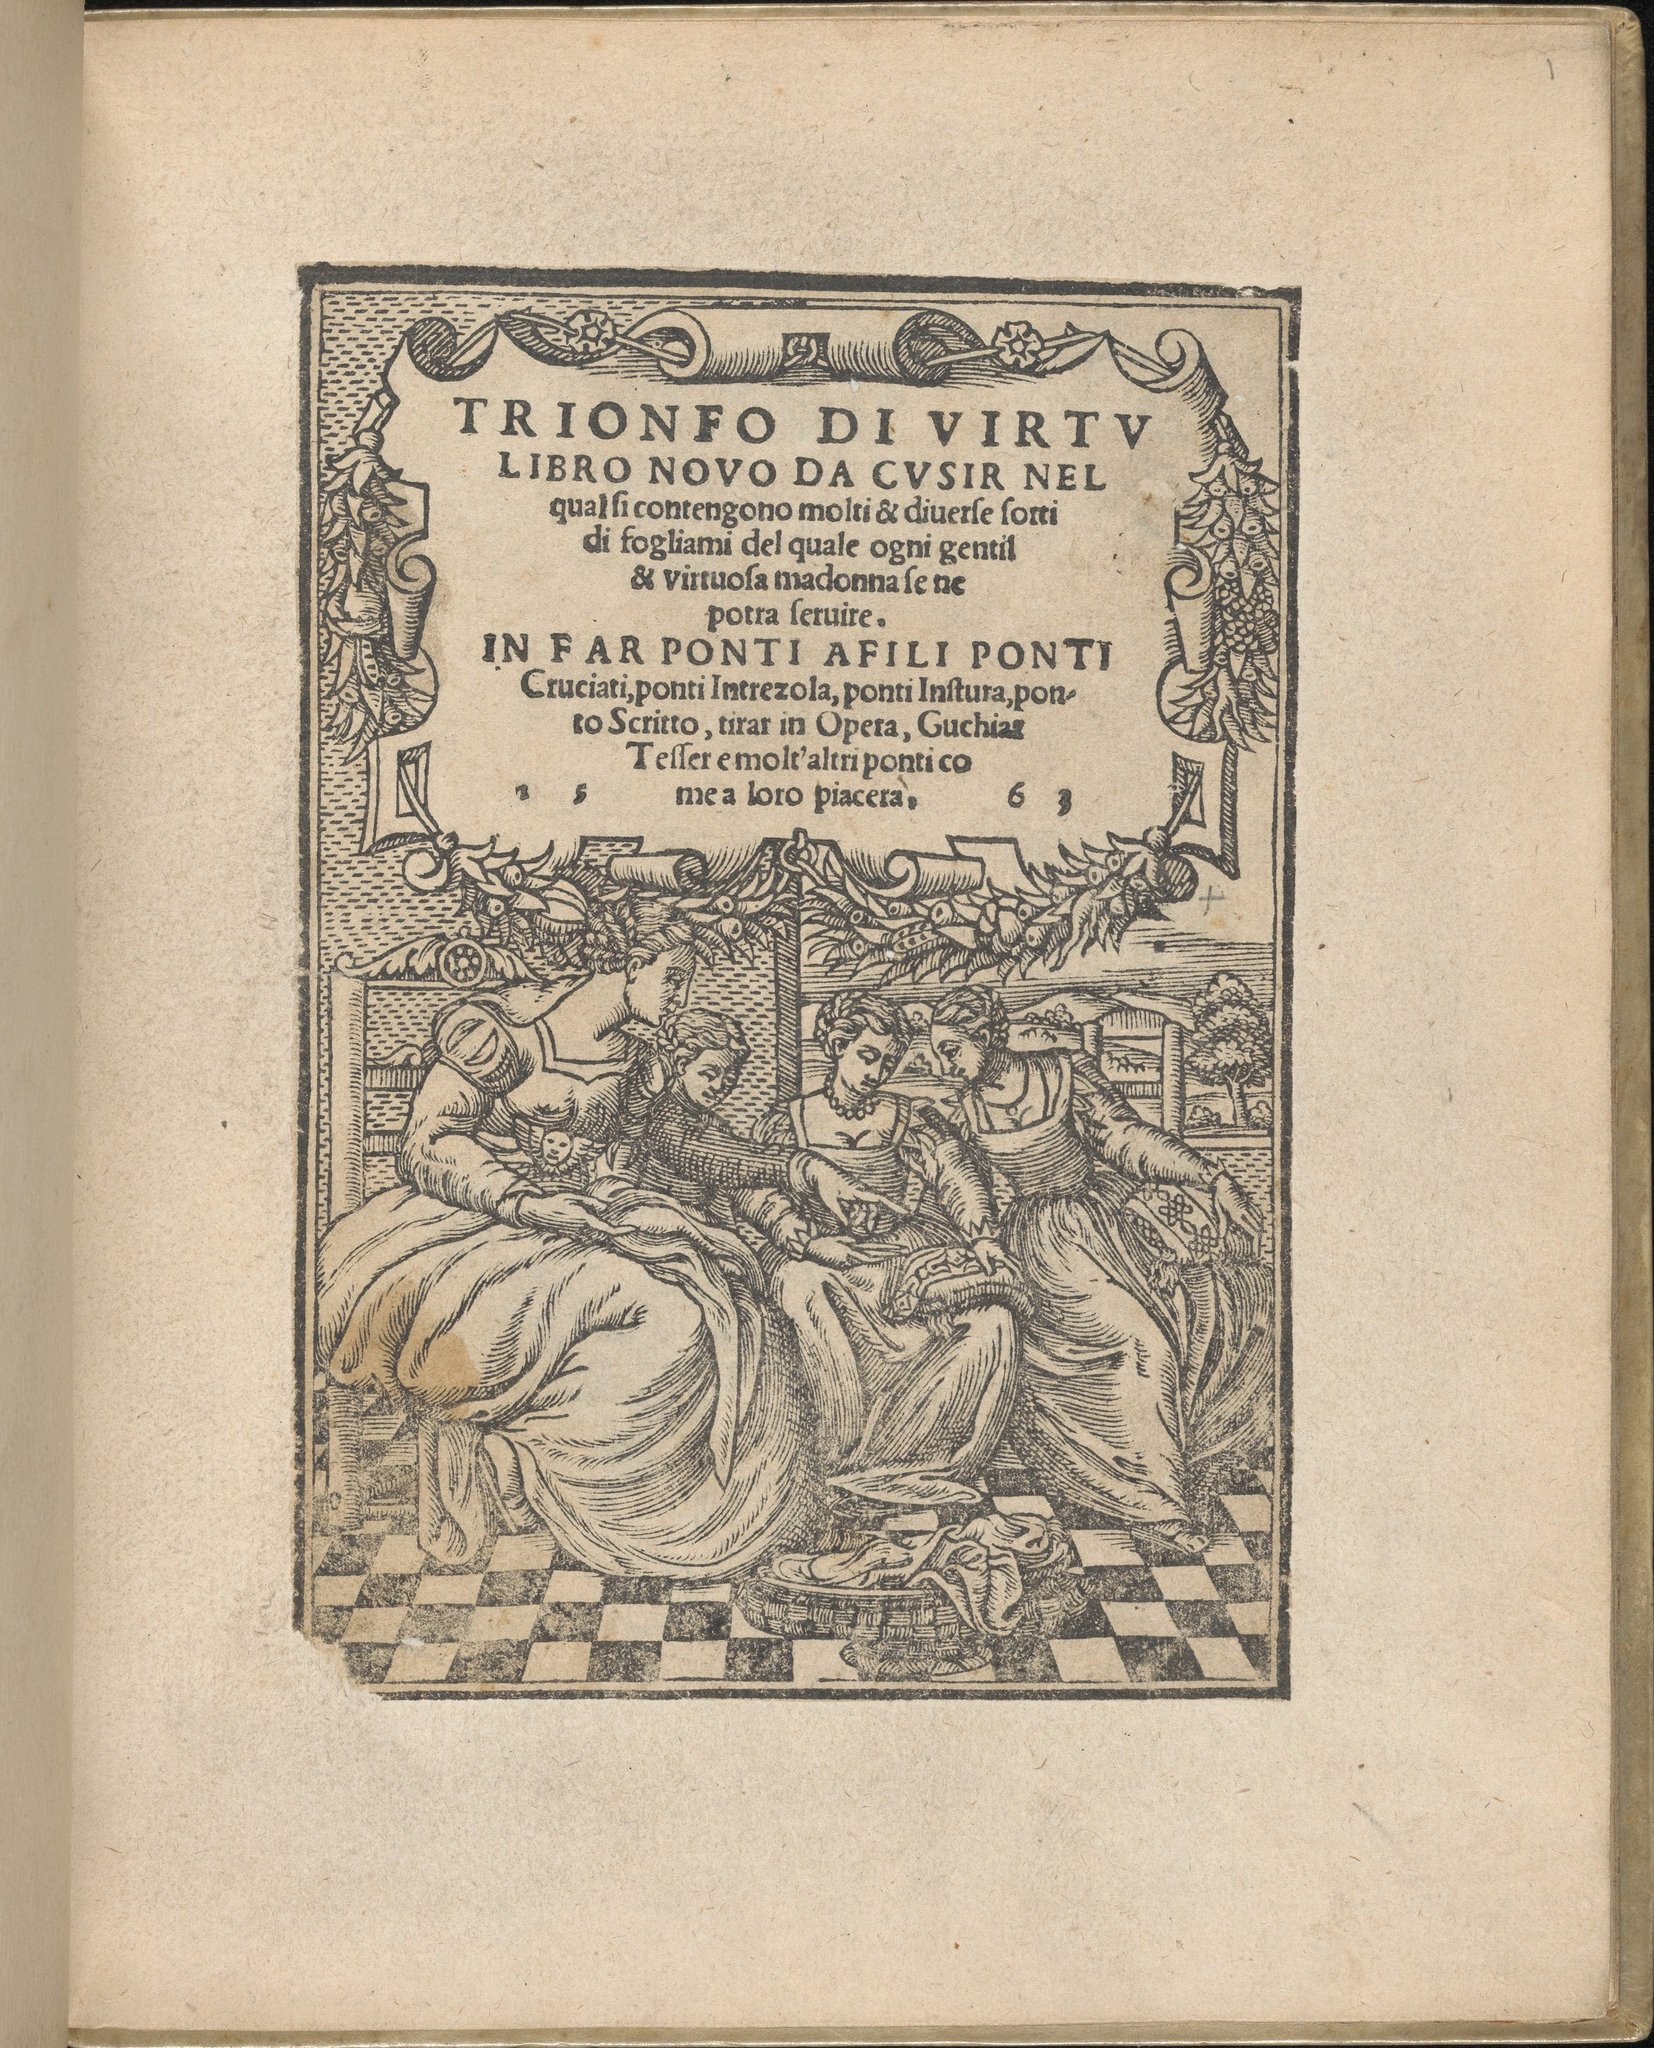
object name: book print ornament architecture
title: Trionfo Di Virtu. Libro Novo..., title page (recto)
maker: matteo pagano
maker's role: publisher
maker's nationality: italian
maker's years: 1515-1588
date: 1563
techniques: woodcut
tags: cartouches,women,working